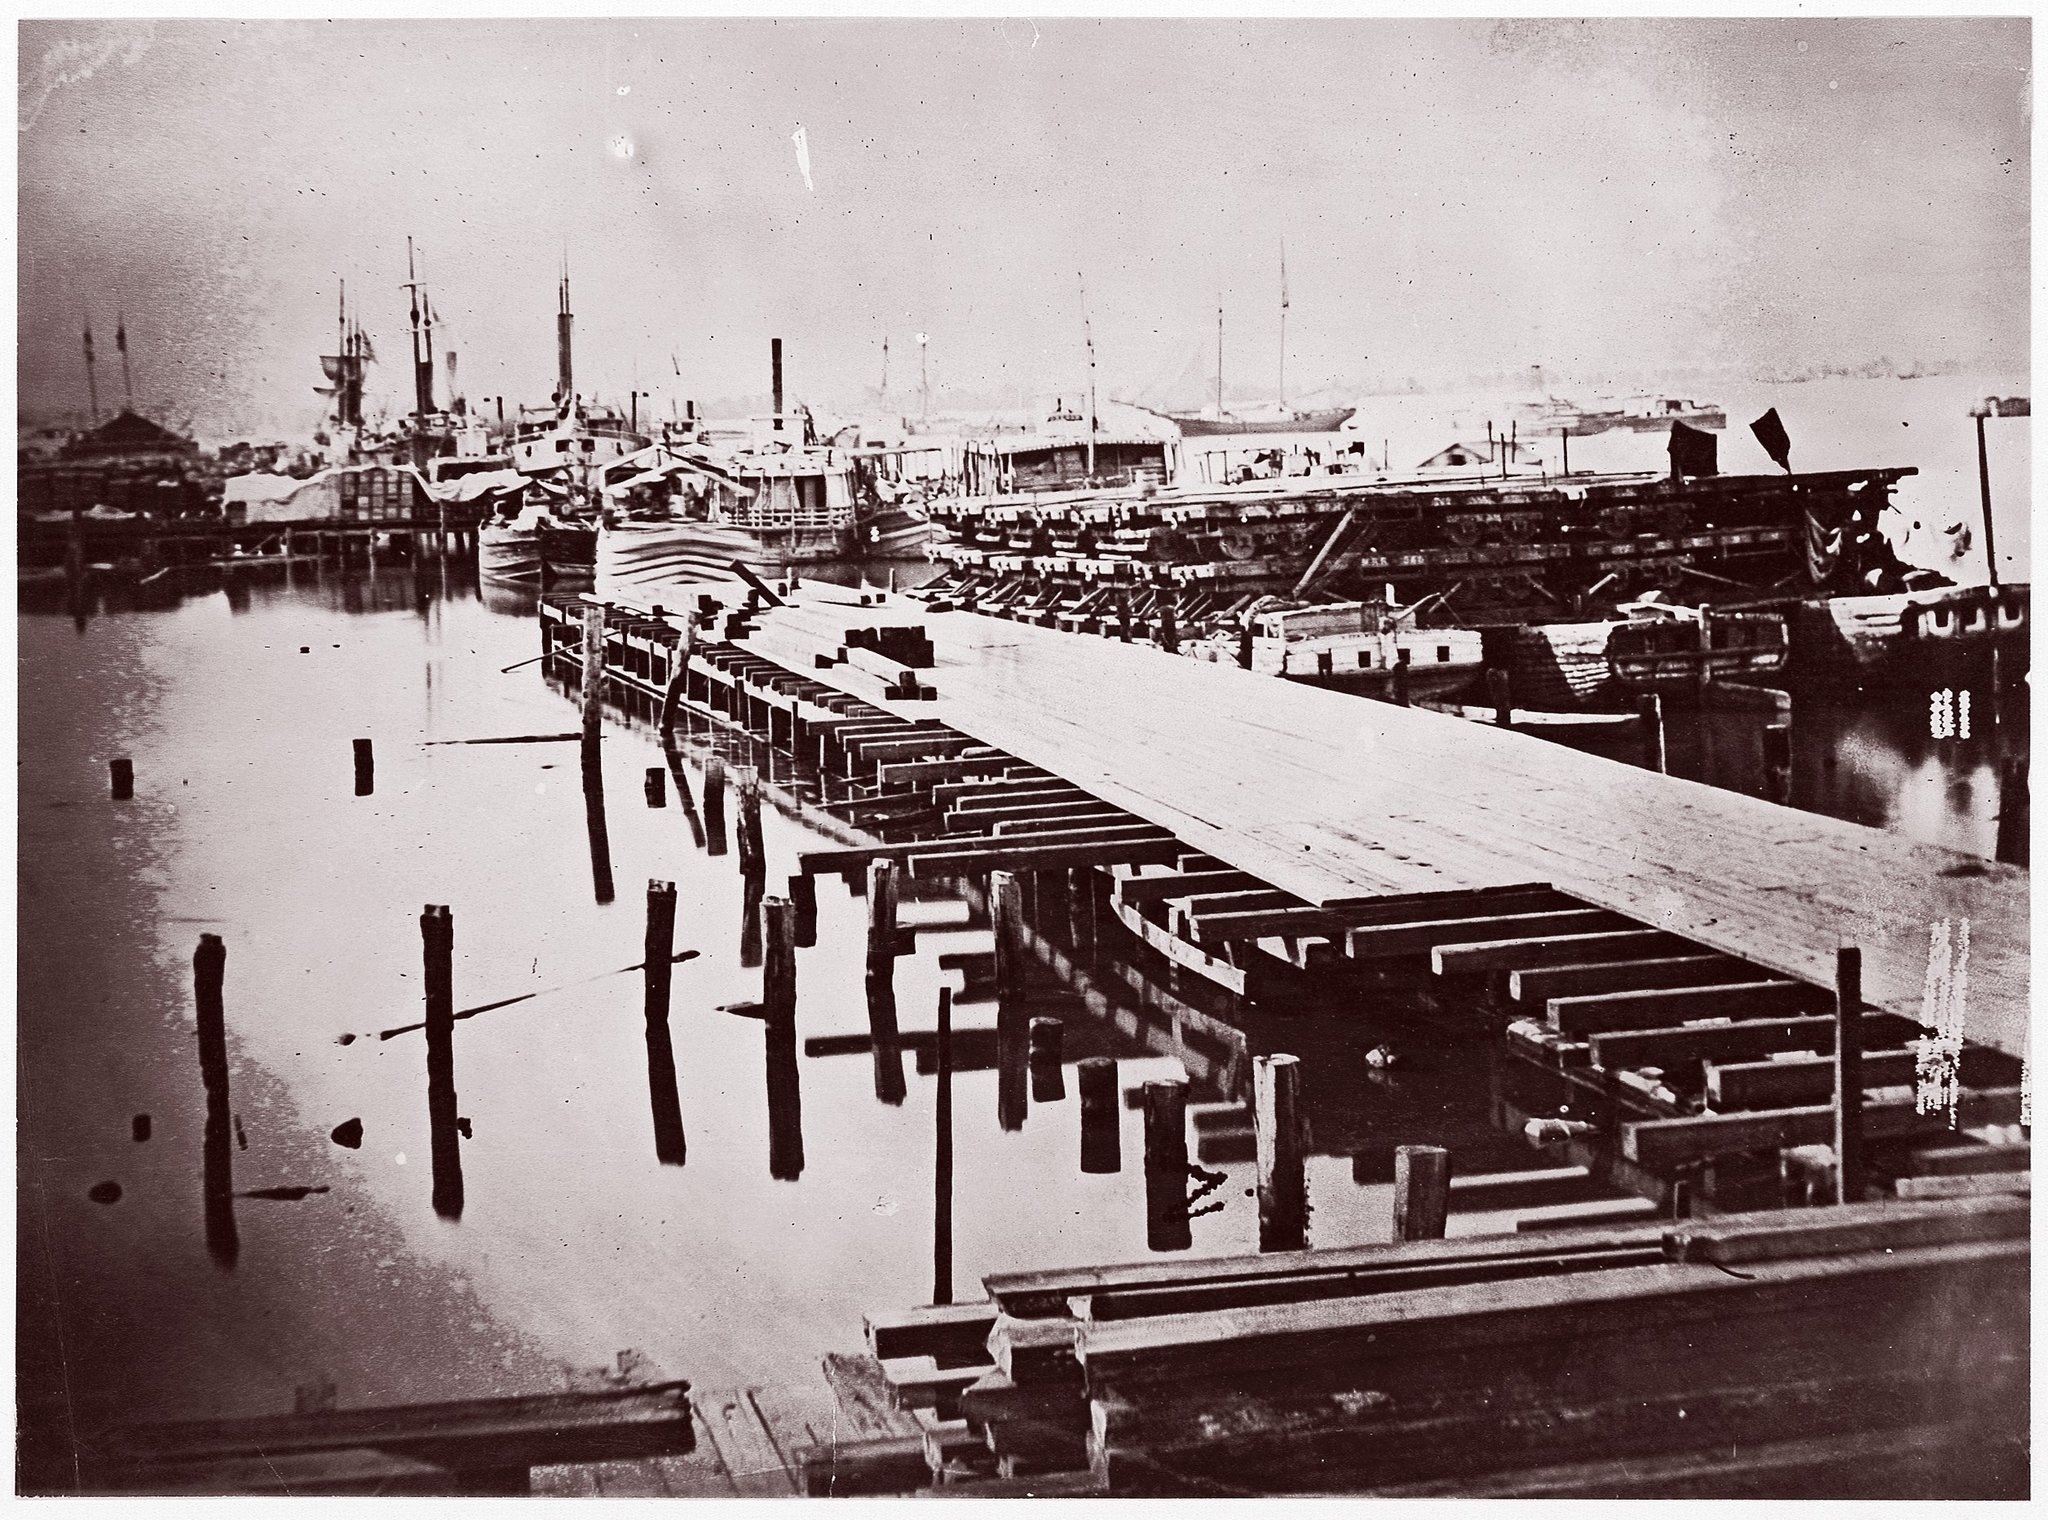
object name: photograph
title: City Point, Virginia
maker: andrew joseph russell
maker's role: artist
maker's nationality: american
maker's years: 1830-1902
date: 1861-1865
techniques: albumen silver print, glass negative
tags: docks,boats